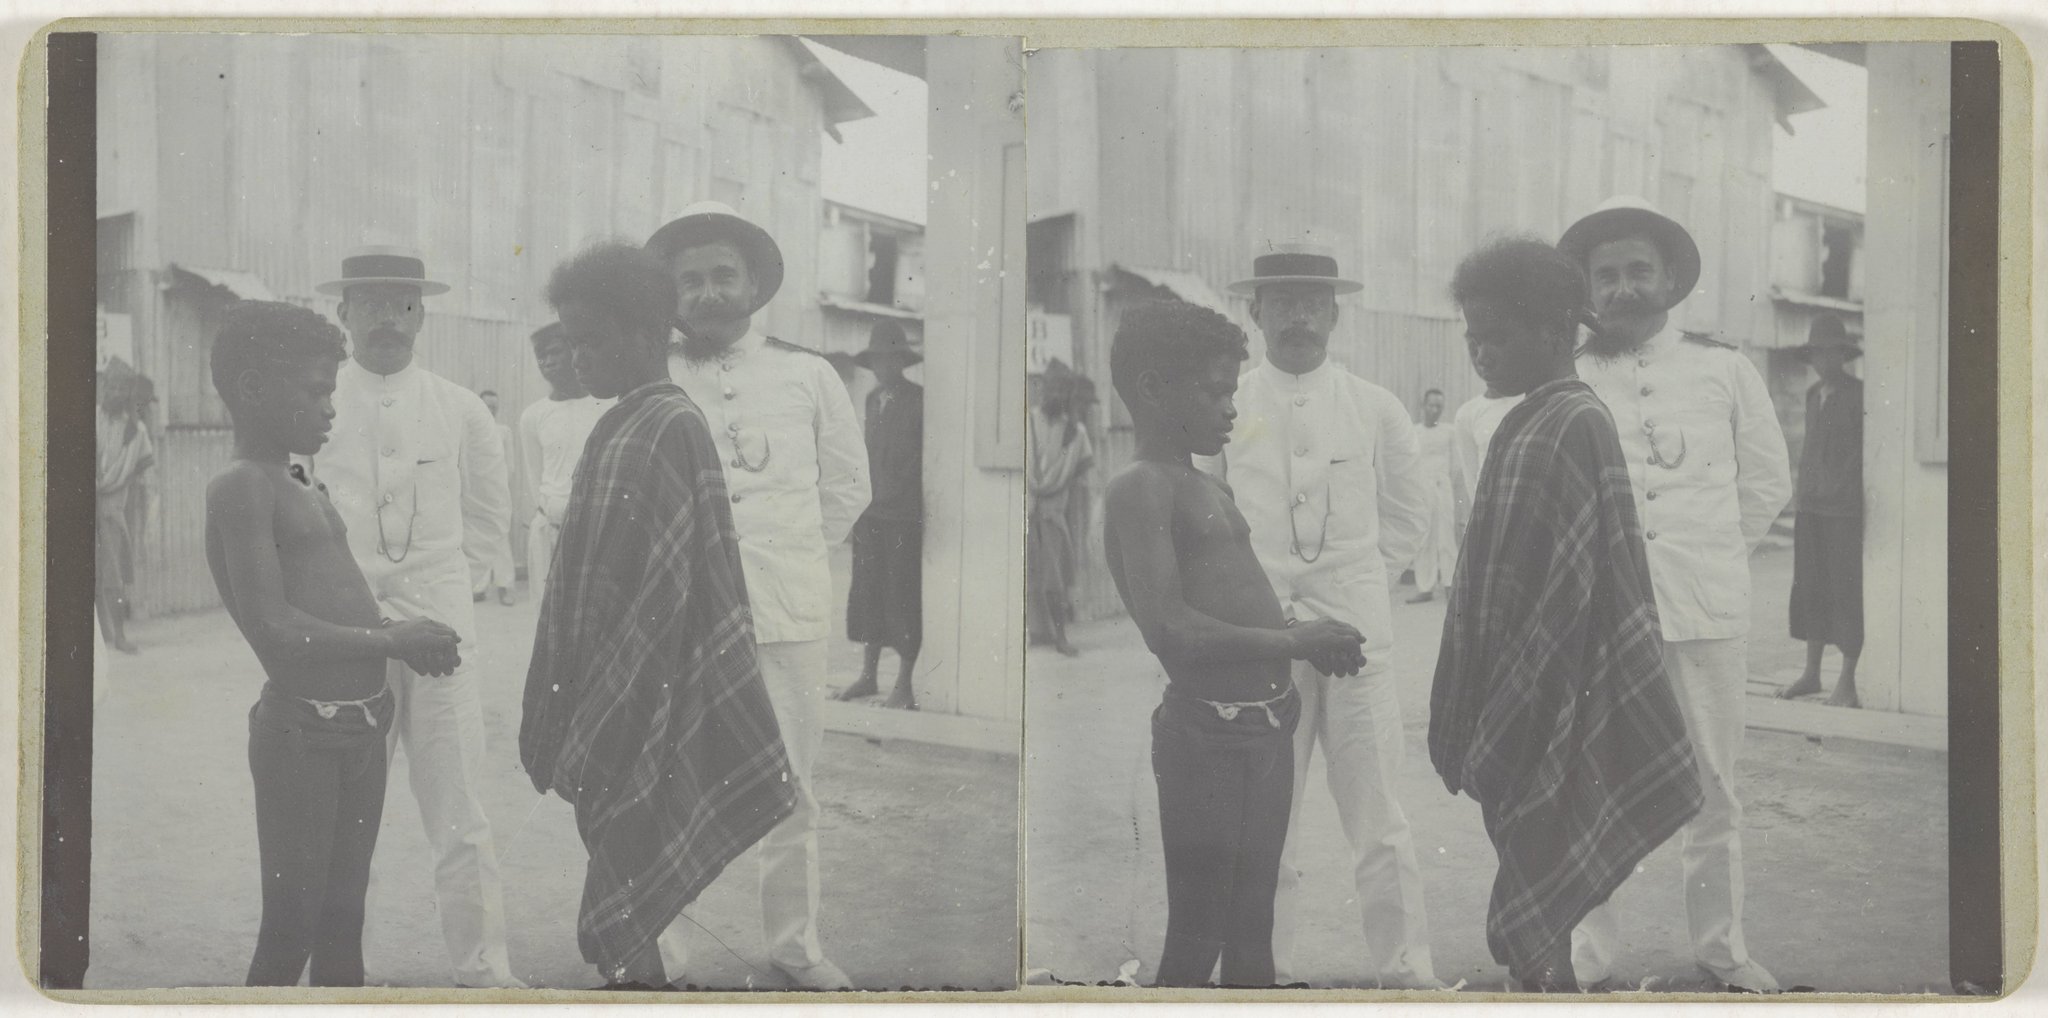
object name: stereograph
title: Twee Europeanen te midden van enkele Molukse inwoners van Dobo, Aru-eilanden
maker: Anonymous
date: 1900-1940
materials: paper, cardboard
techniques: gelatin silver print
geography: aru-eilanden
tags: adult man, street